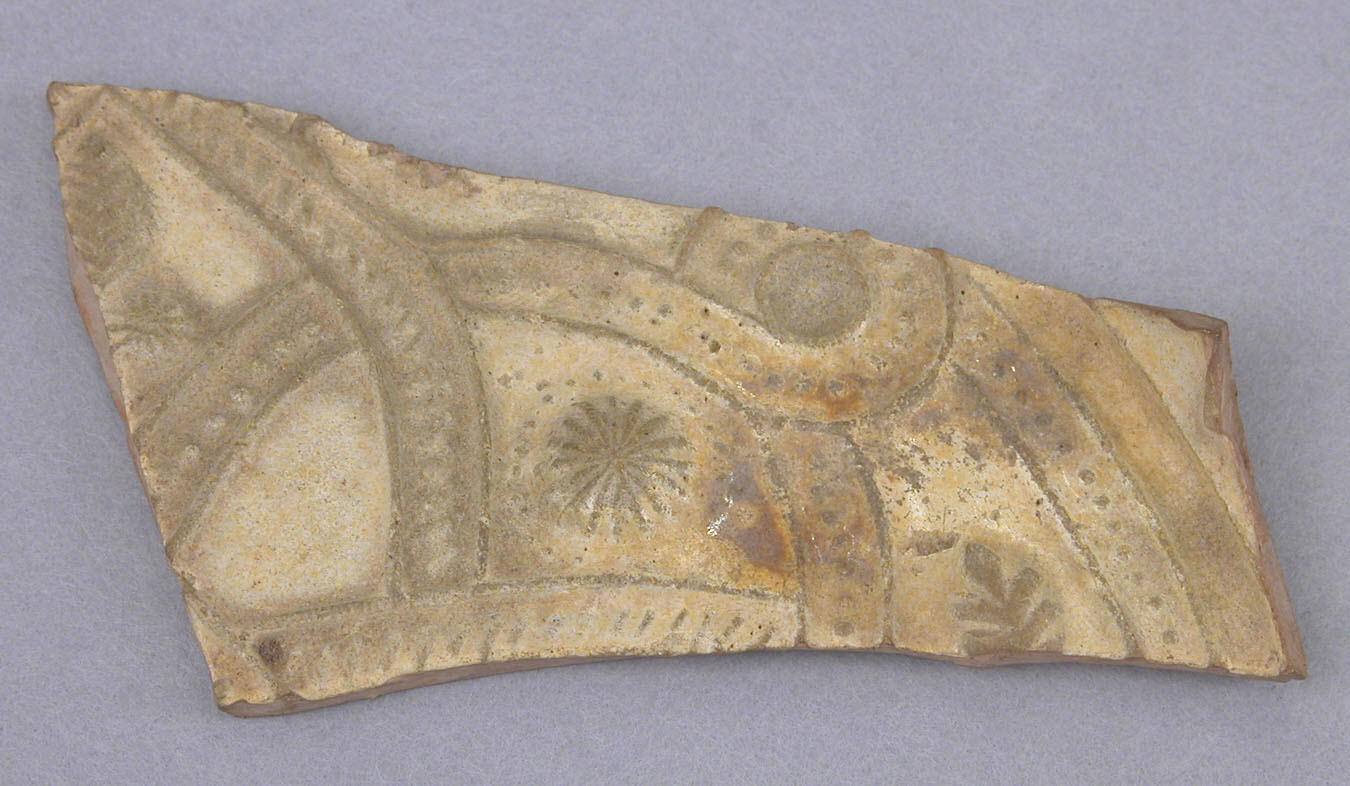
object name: fragment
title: Fragment with Interlace Design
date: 801-900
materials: earthenware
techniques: glazing, molding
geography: iraq